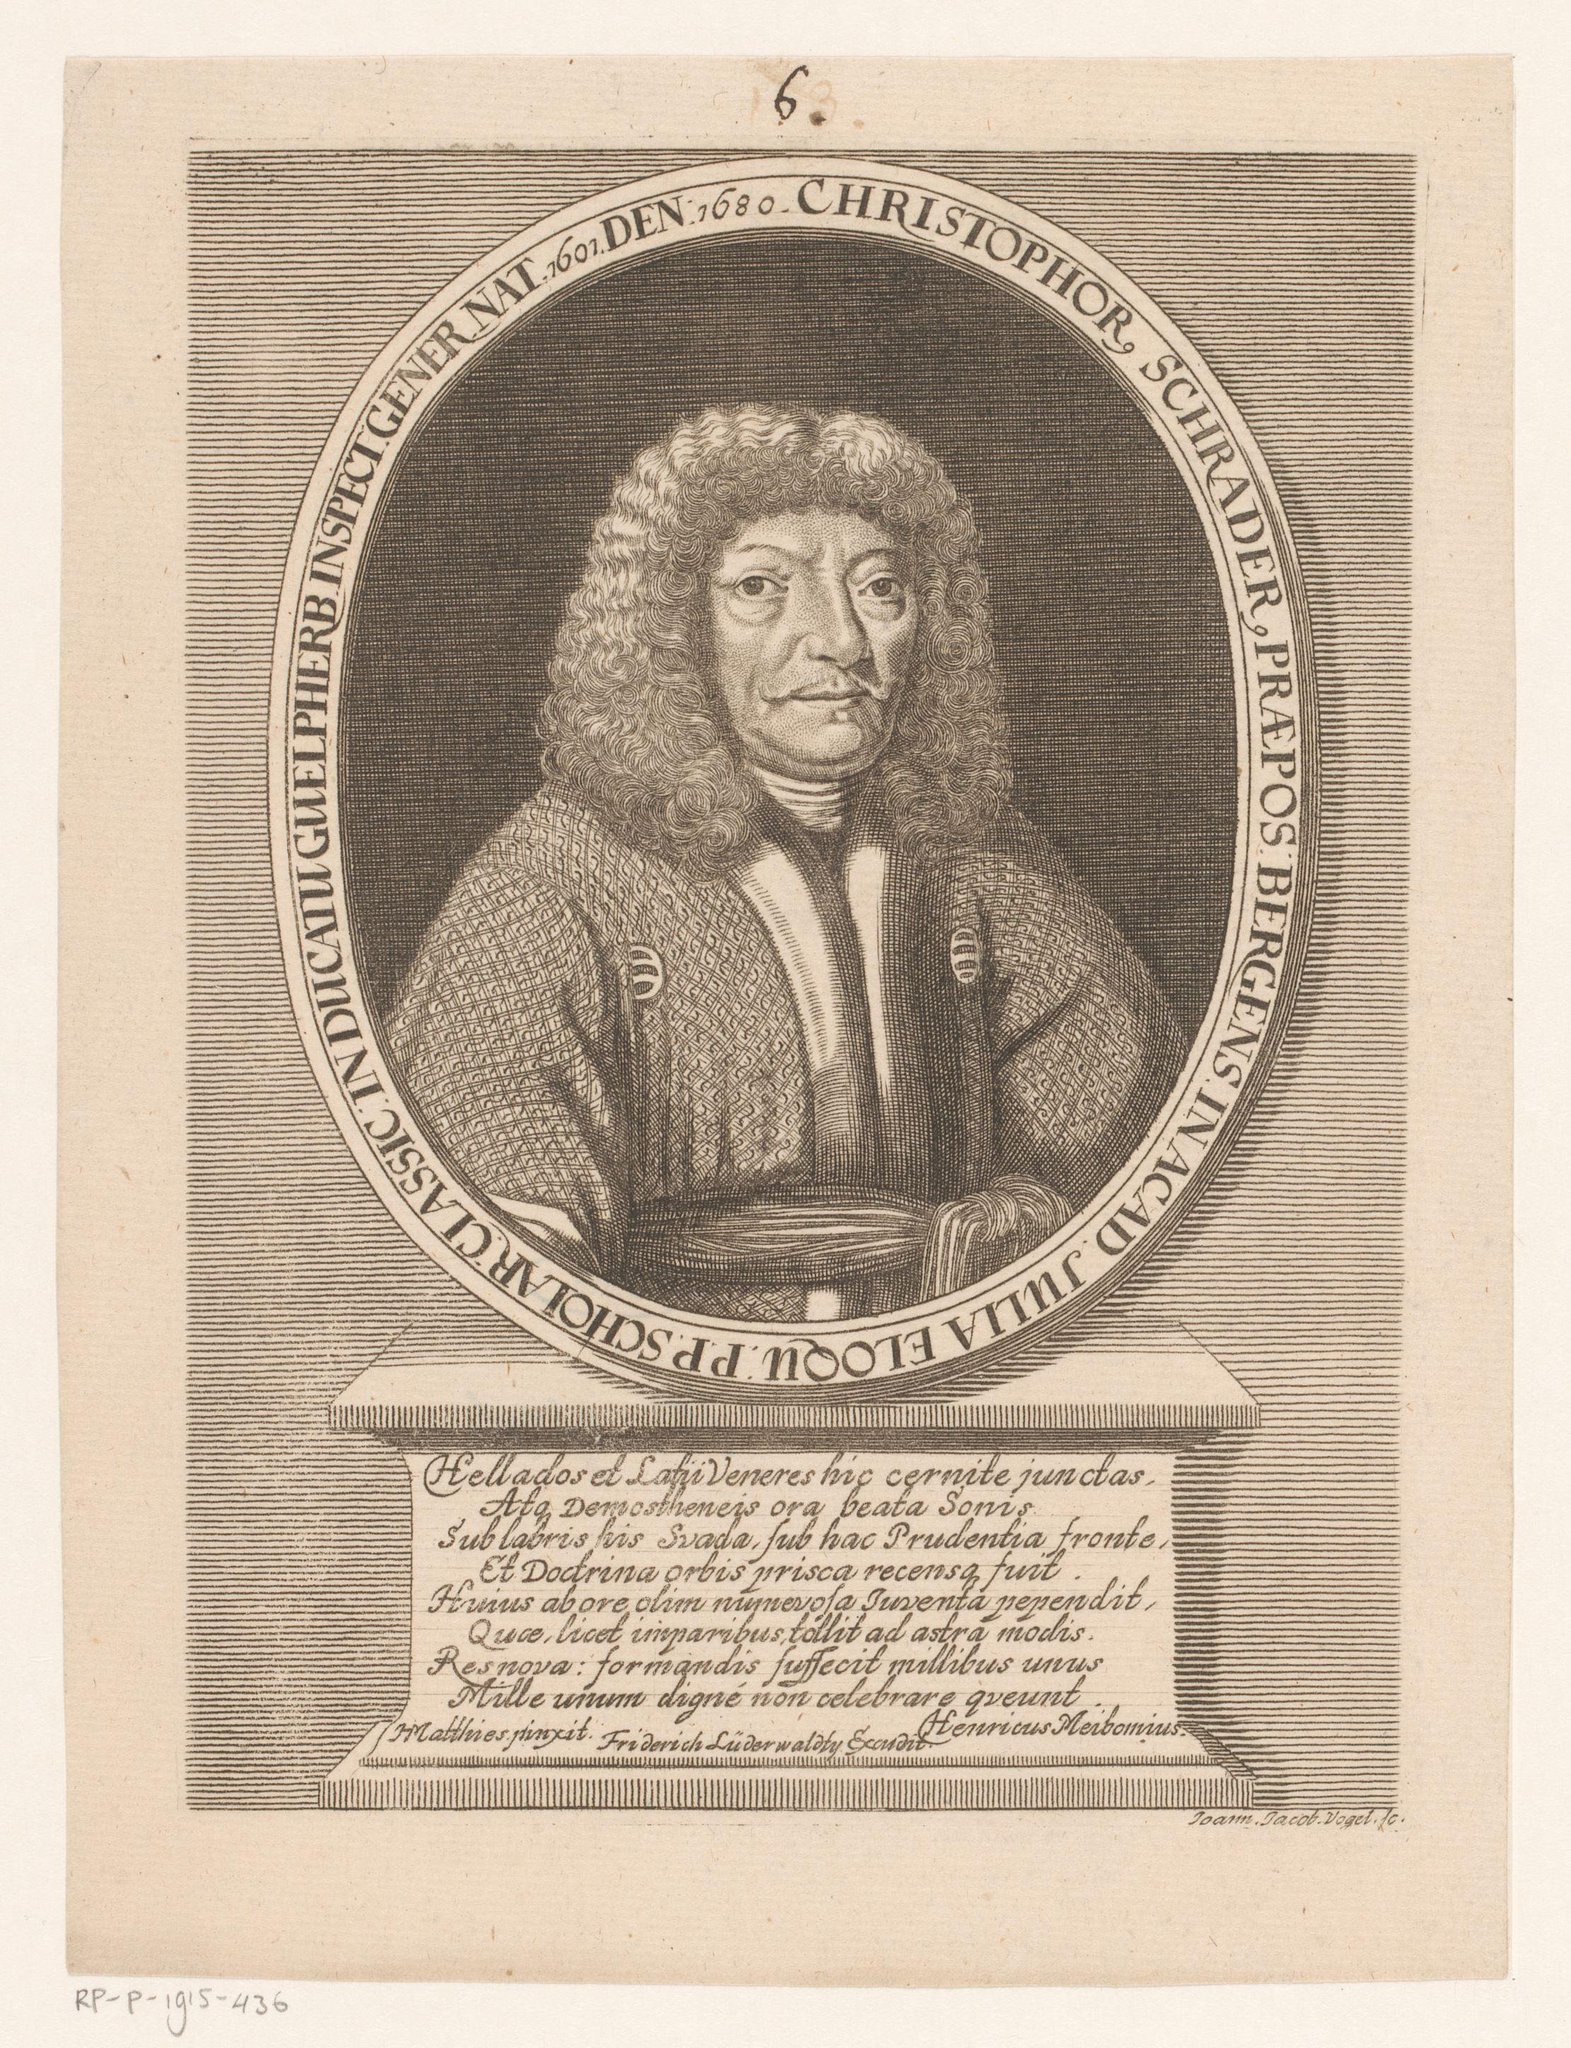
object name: print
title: Portret van Christoph Schrader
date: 1693-1700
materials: paper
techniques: engraving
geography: germany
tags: historical persons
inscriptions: number: ‘6’, collector's mark: Lugt 2228